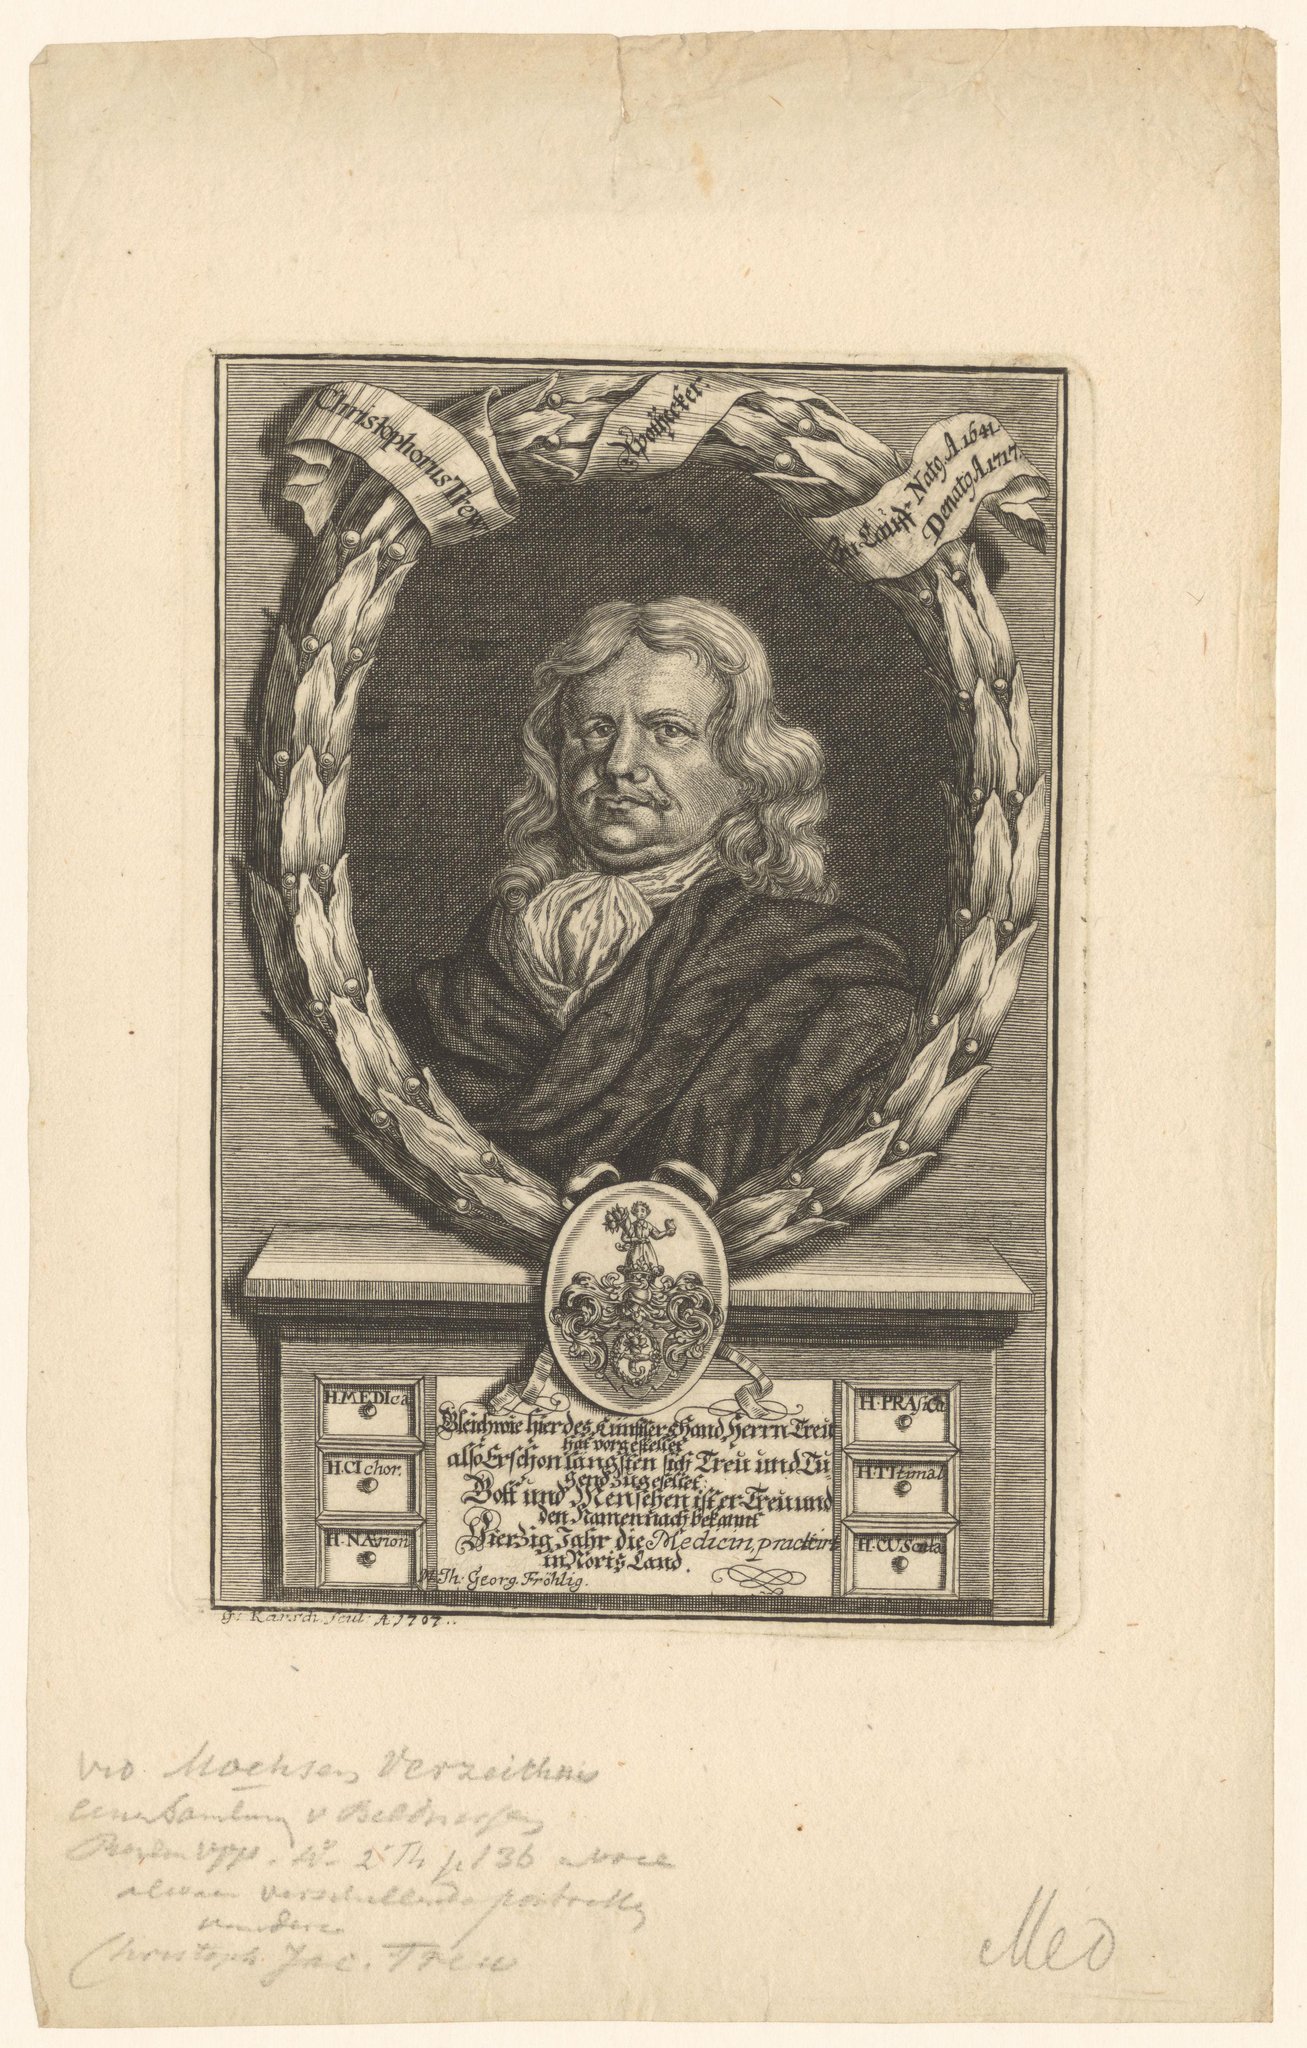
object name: print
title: Portret van Christoph Trew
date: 1707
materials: paper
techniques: engraving, etching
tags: historical persons, physician, doctor (+ portrait of scholar, scientist)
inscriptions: collector's mark: Lugt 2228